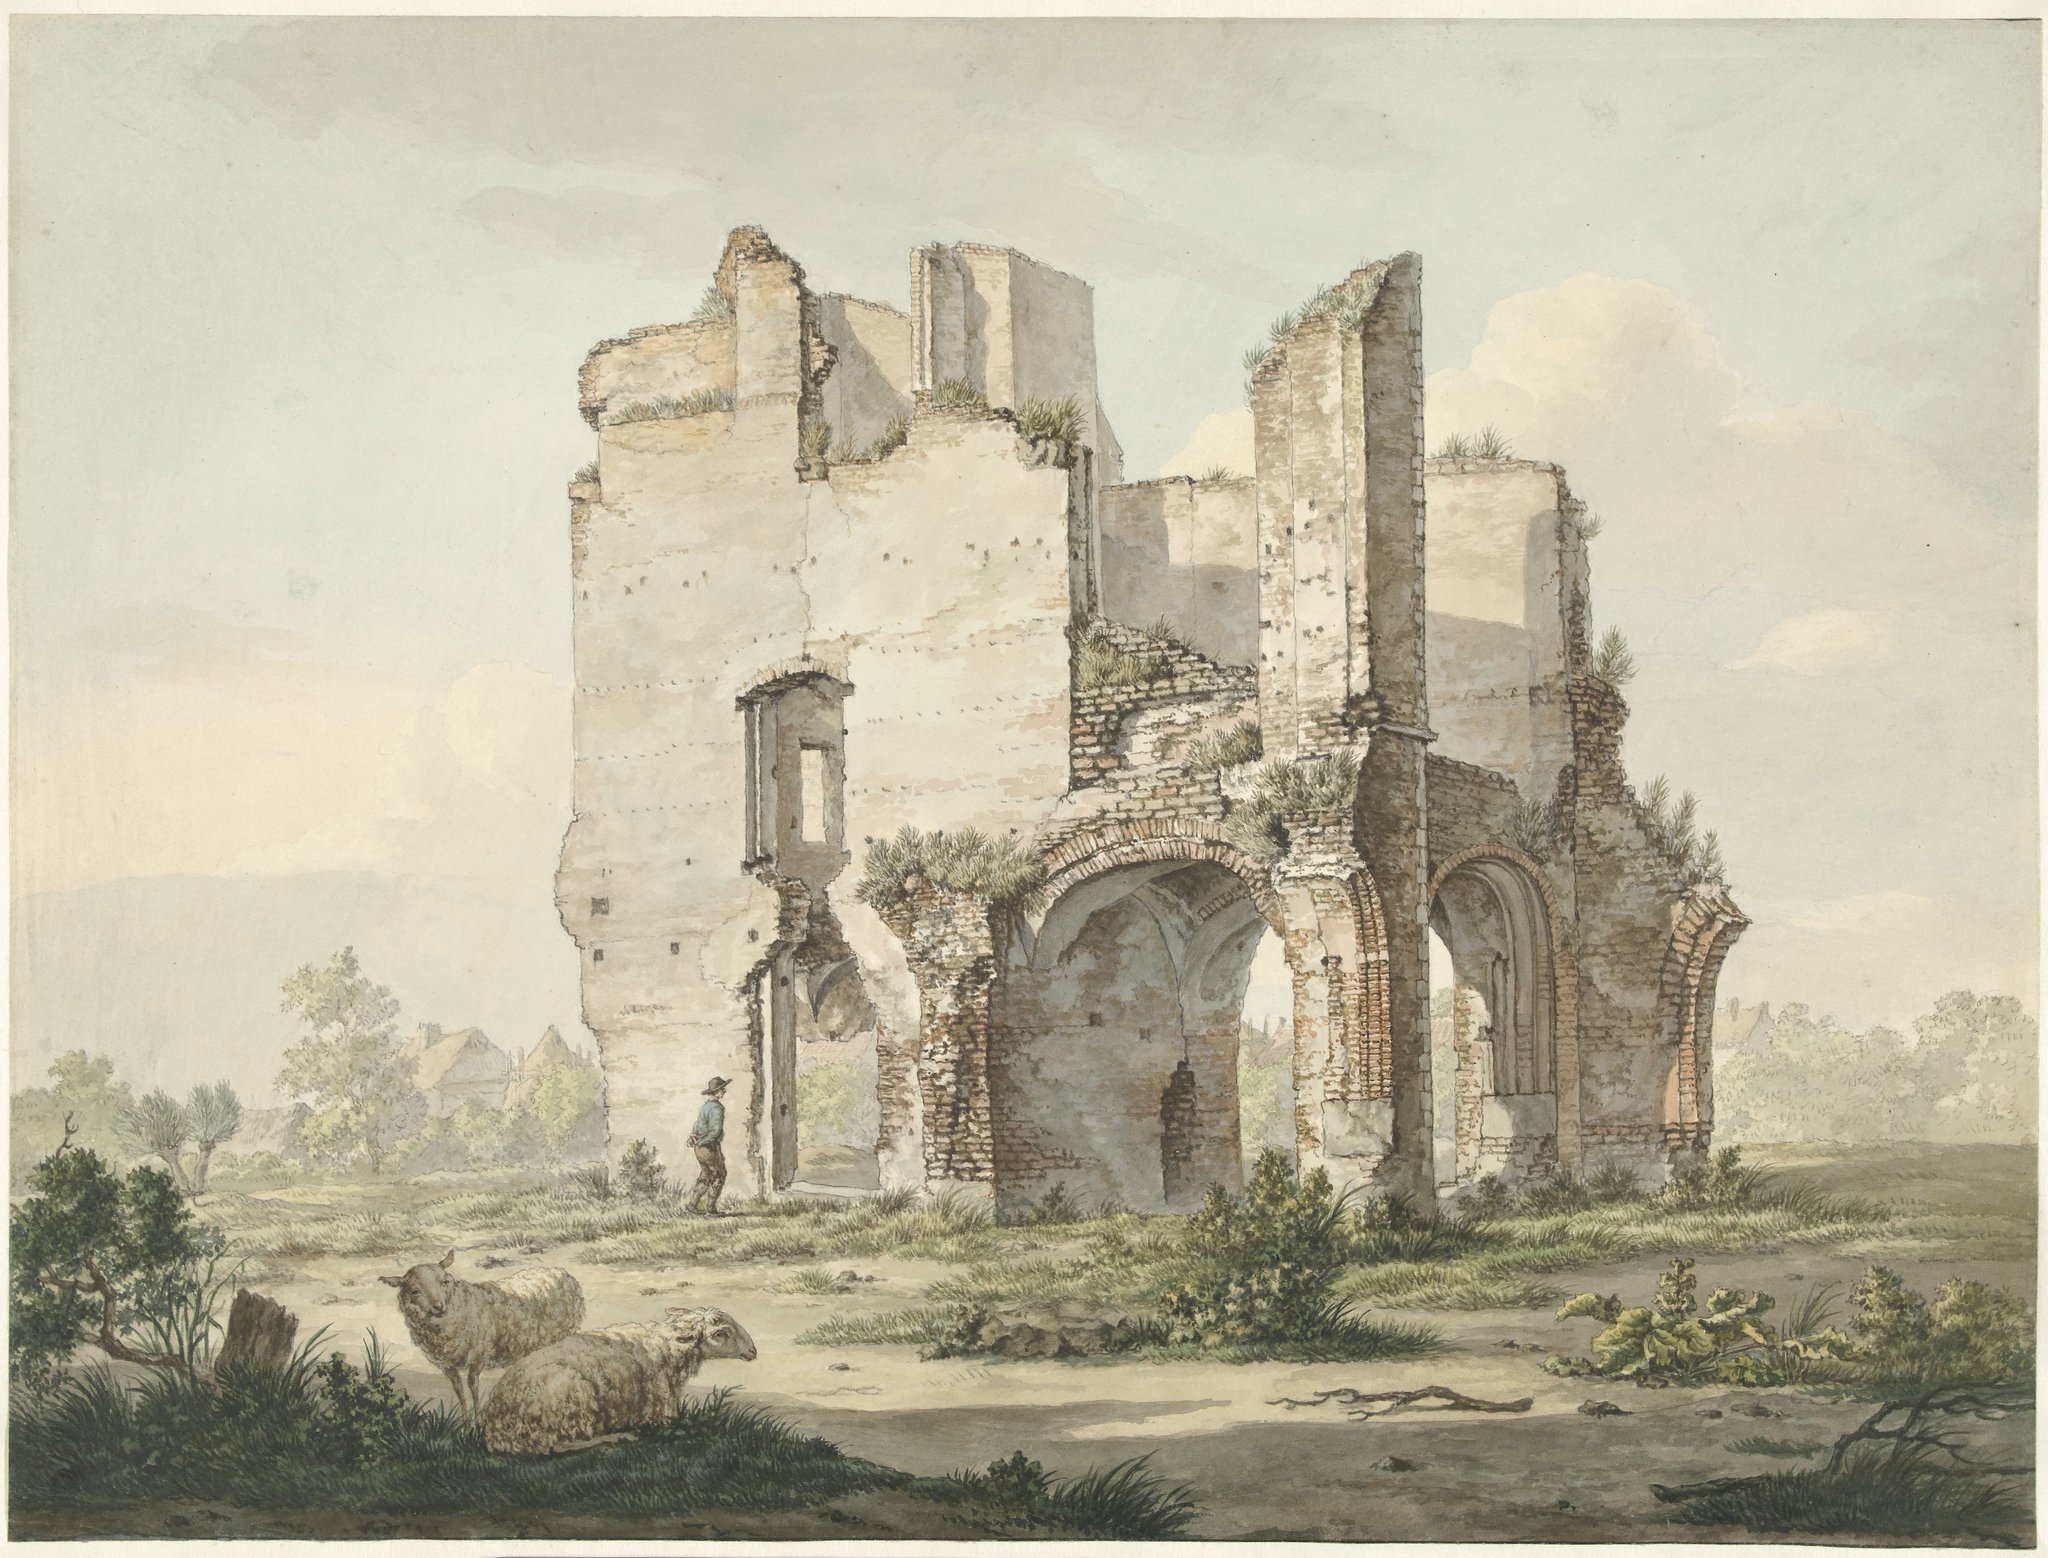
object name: watercolor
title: De ruïne van de Abdij van Rijnsburg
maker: johannes van lexmond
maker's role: draughtsman, print maker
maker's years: 1769-1838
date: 1779-1838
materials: chalk, paper, watercolor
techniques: brush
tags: ruin of a building ~ architecture, abbey, monastery, convent ~ roman catholic church